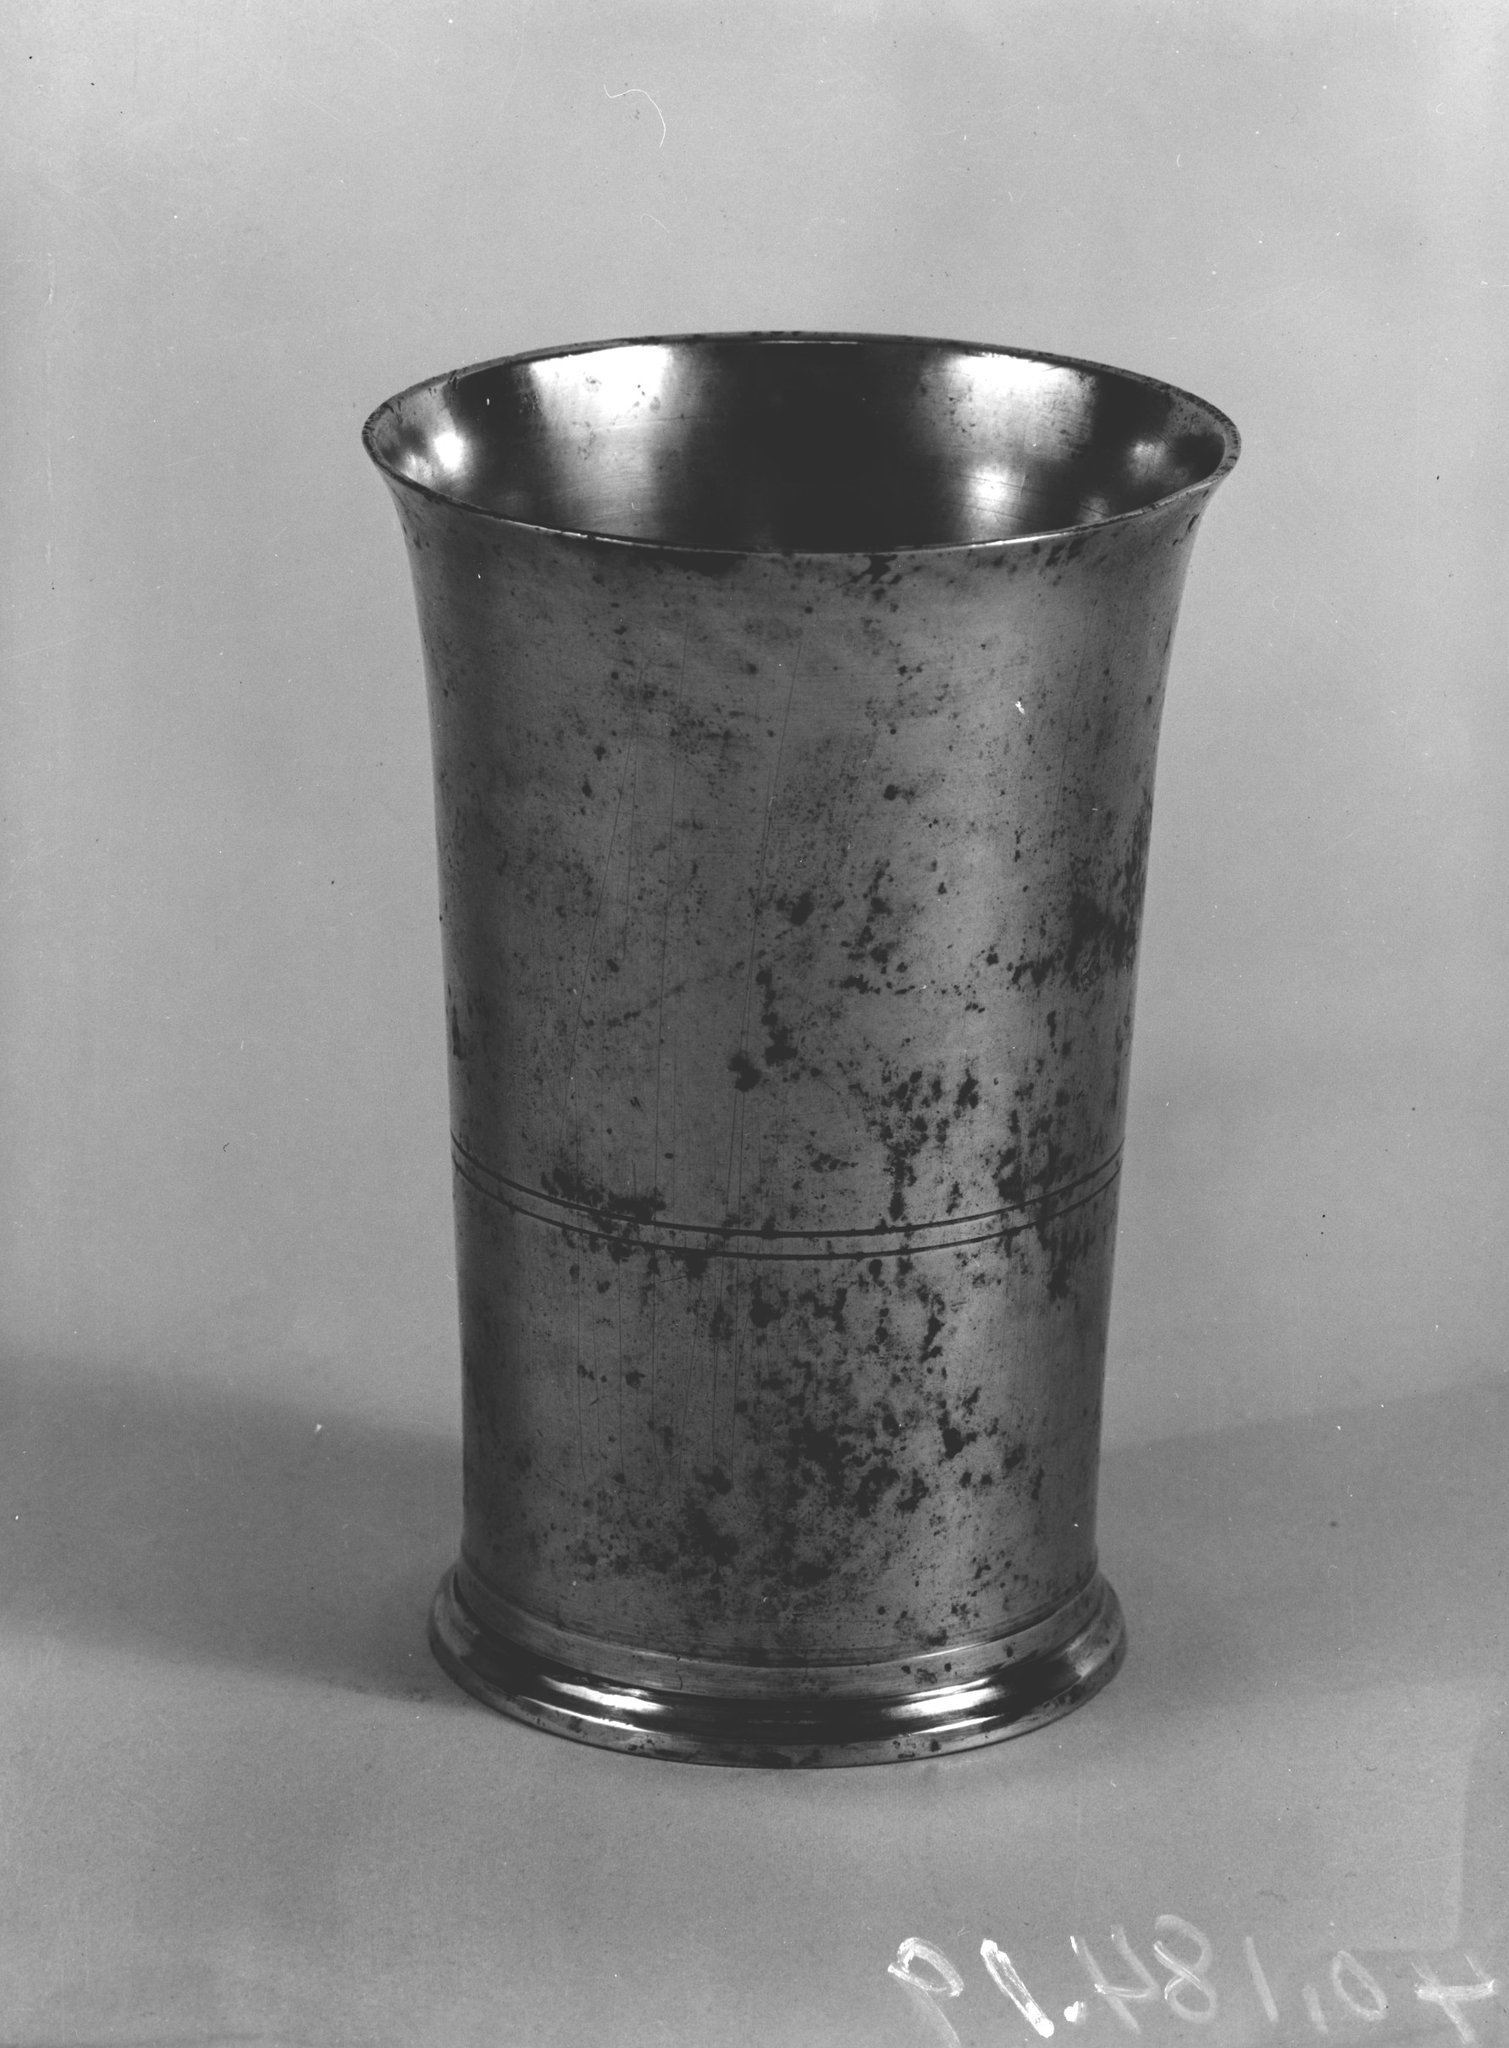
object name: beaker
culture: american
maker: thomas danforth boardman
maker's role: maker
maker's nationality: american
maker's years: 1784-1873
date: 1810-1850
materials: pewter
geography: united states